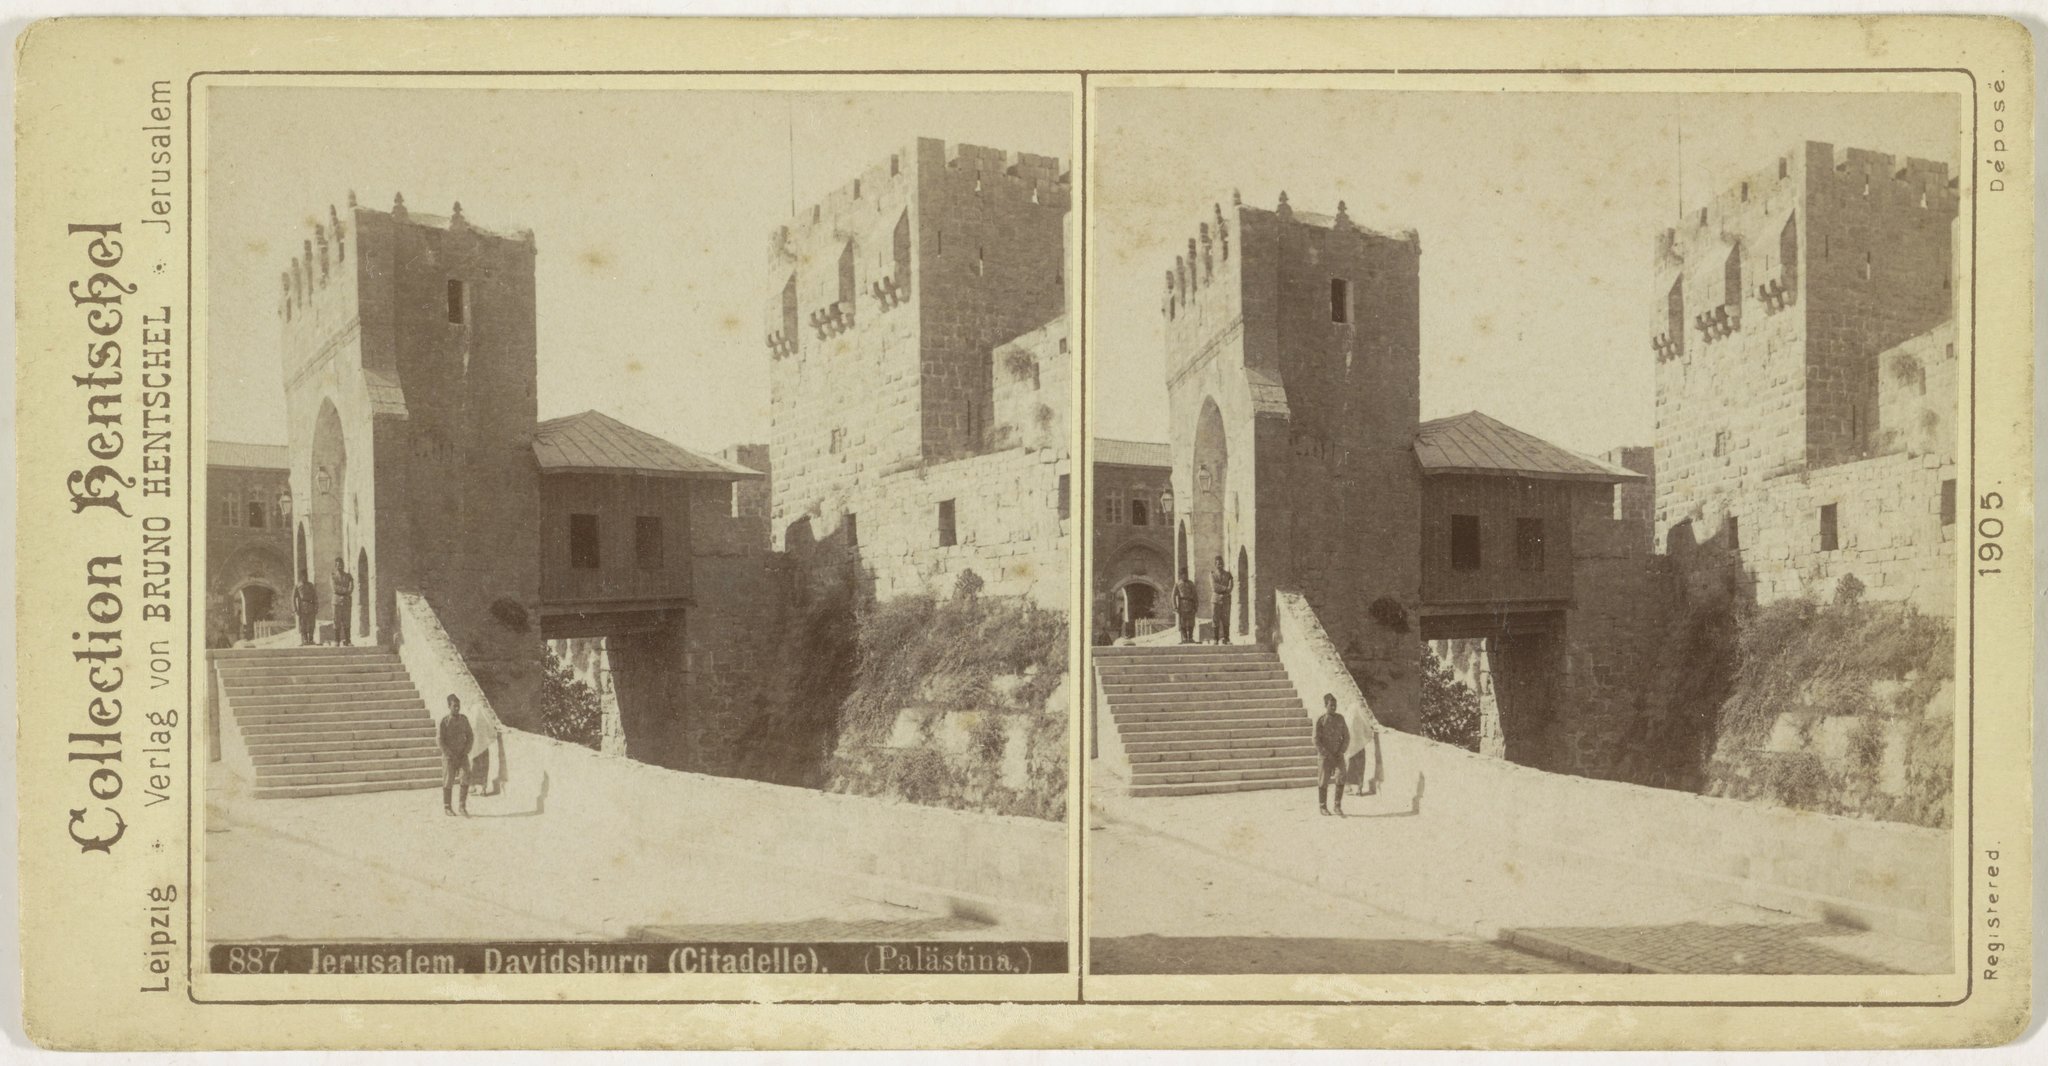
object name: stereograph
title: David Citadel, Jeruzalem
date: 1905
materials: cardboard, paper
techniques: albumen print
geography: tower of david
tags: palace, tower of david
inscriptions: number: ‘887.’, inscription: ‘Déposé.’, inscription: ‘Registered.’